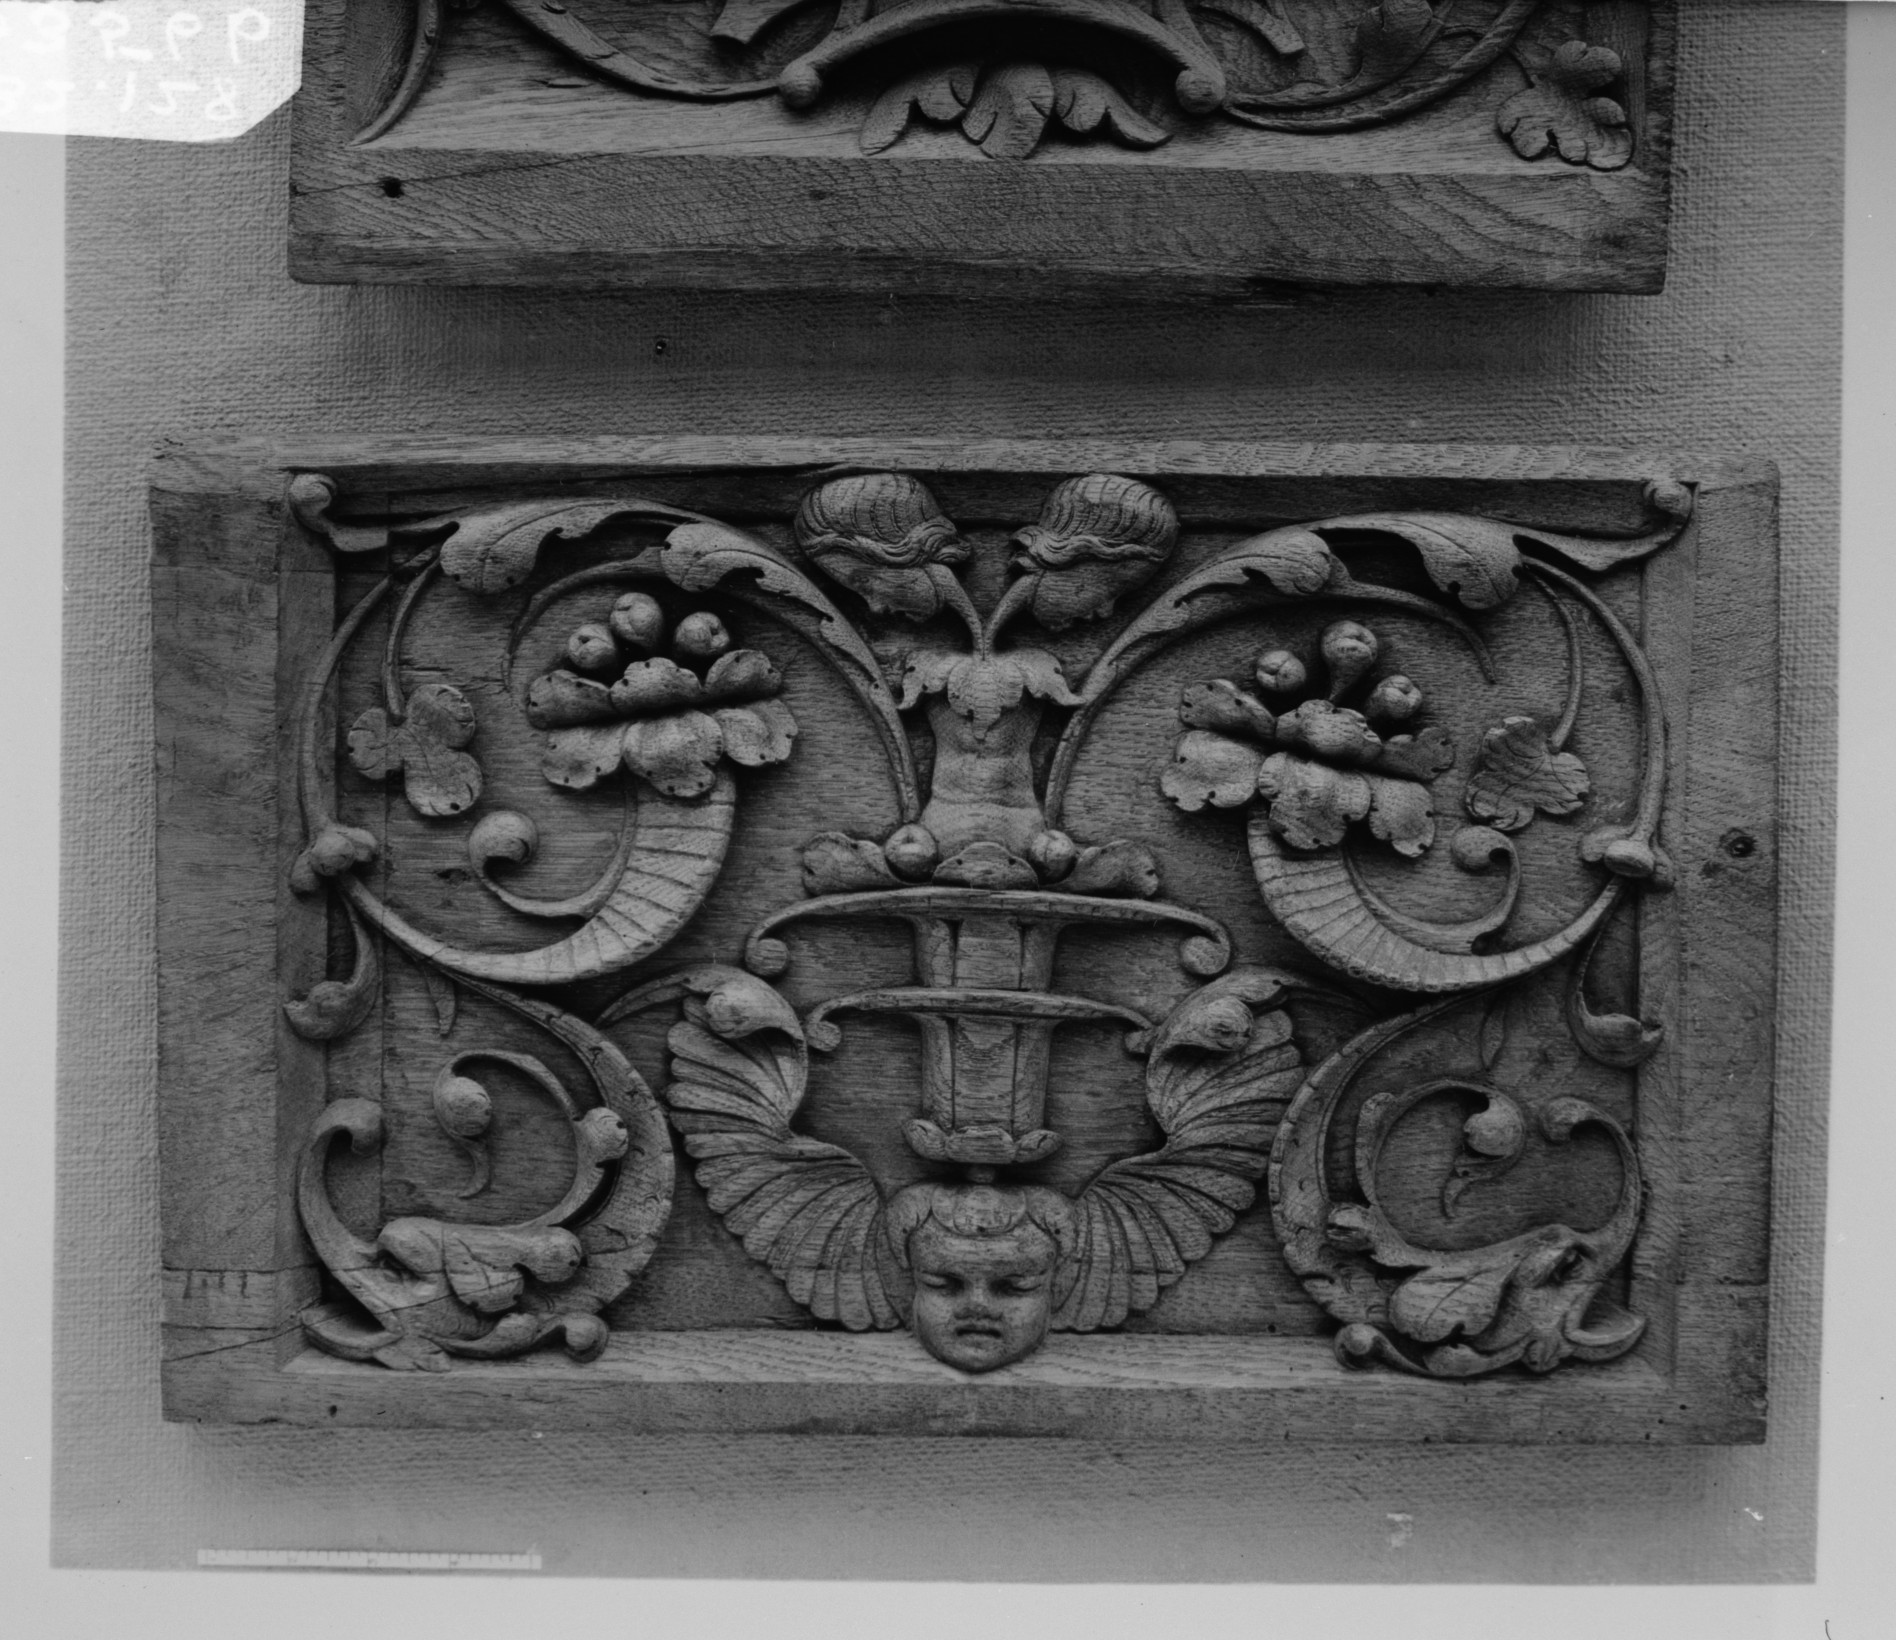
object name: panel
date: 1501-1600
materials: wood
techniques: carving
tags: faces,flowers,leaves